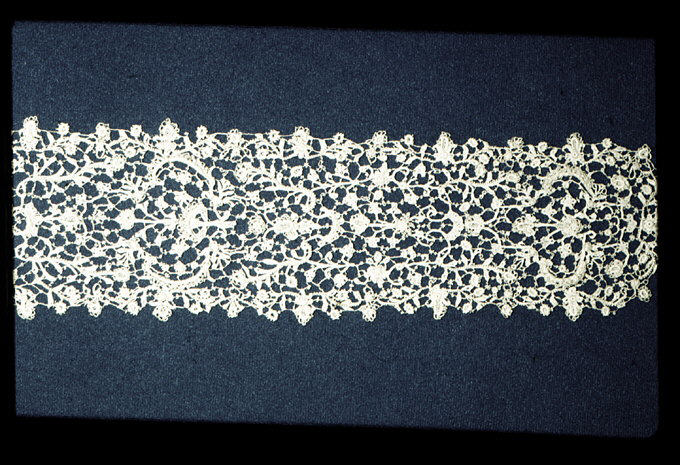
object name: lappet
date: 1601-1700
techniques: lace